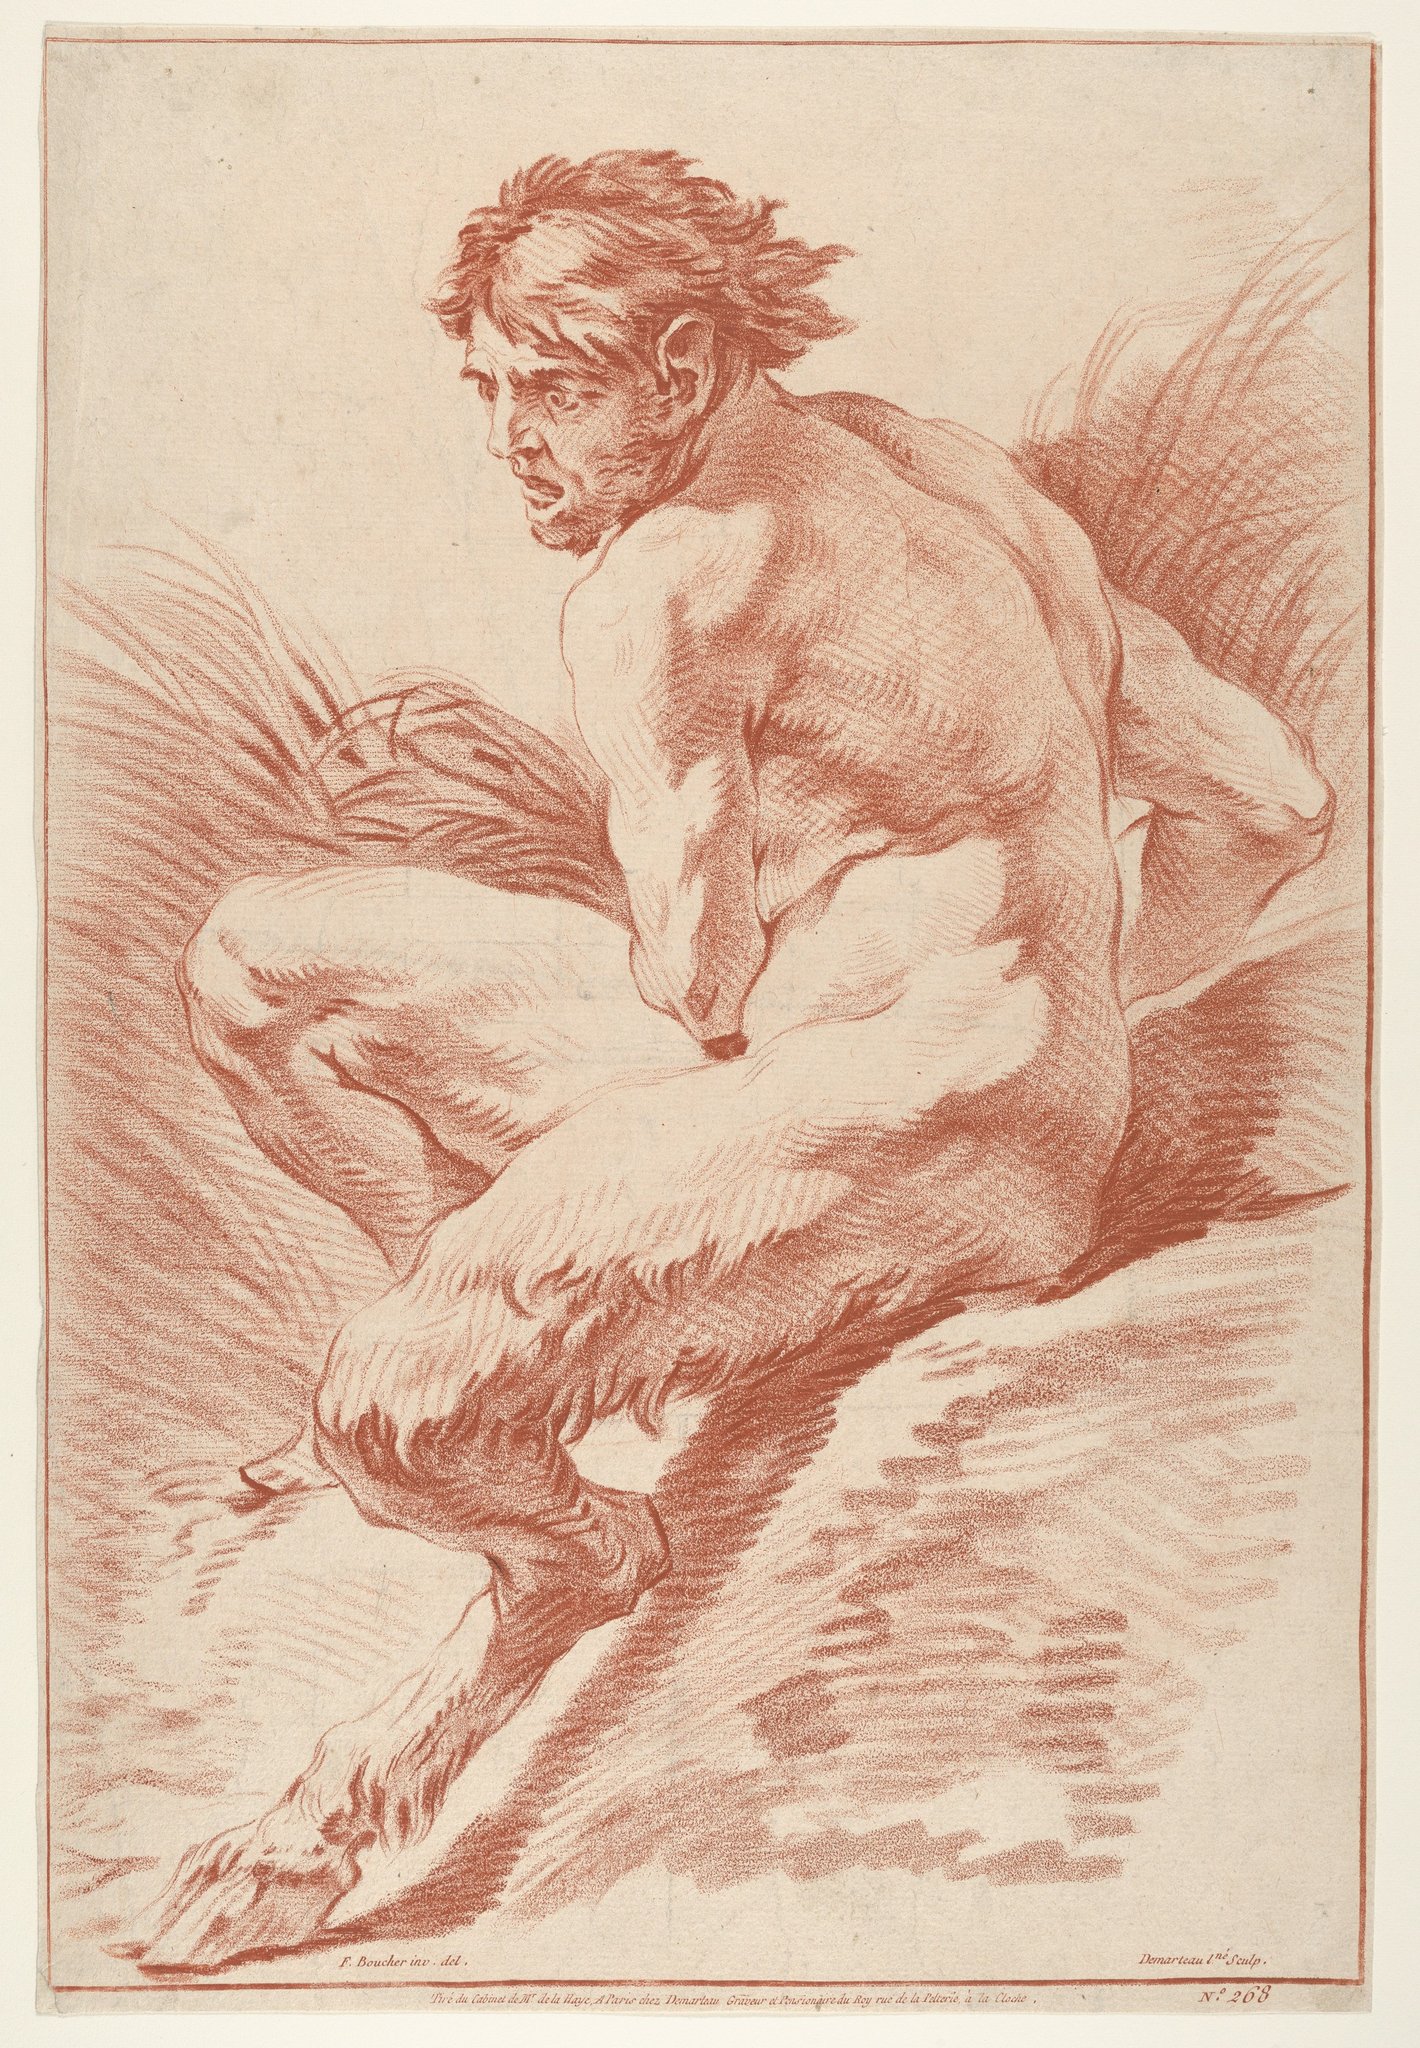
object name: print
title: Satyr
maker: gilles demarteau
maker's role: artist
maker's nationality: french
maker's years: 1722-1776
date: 1740-1770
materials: ink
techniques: printmaking, engraving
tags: satyrs